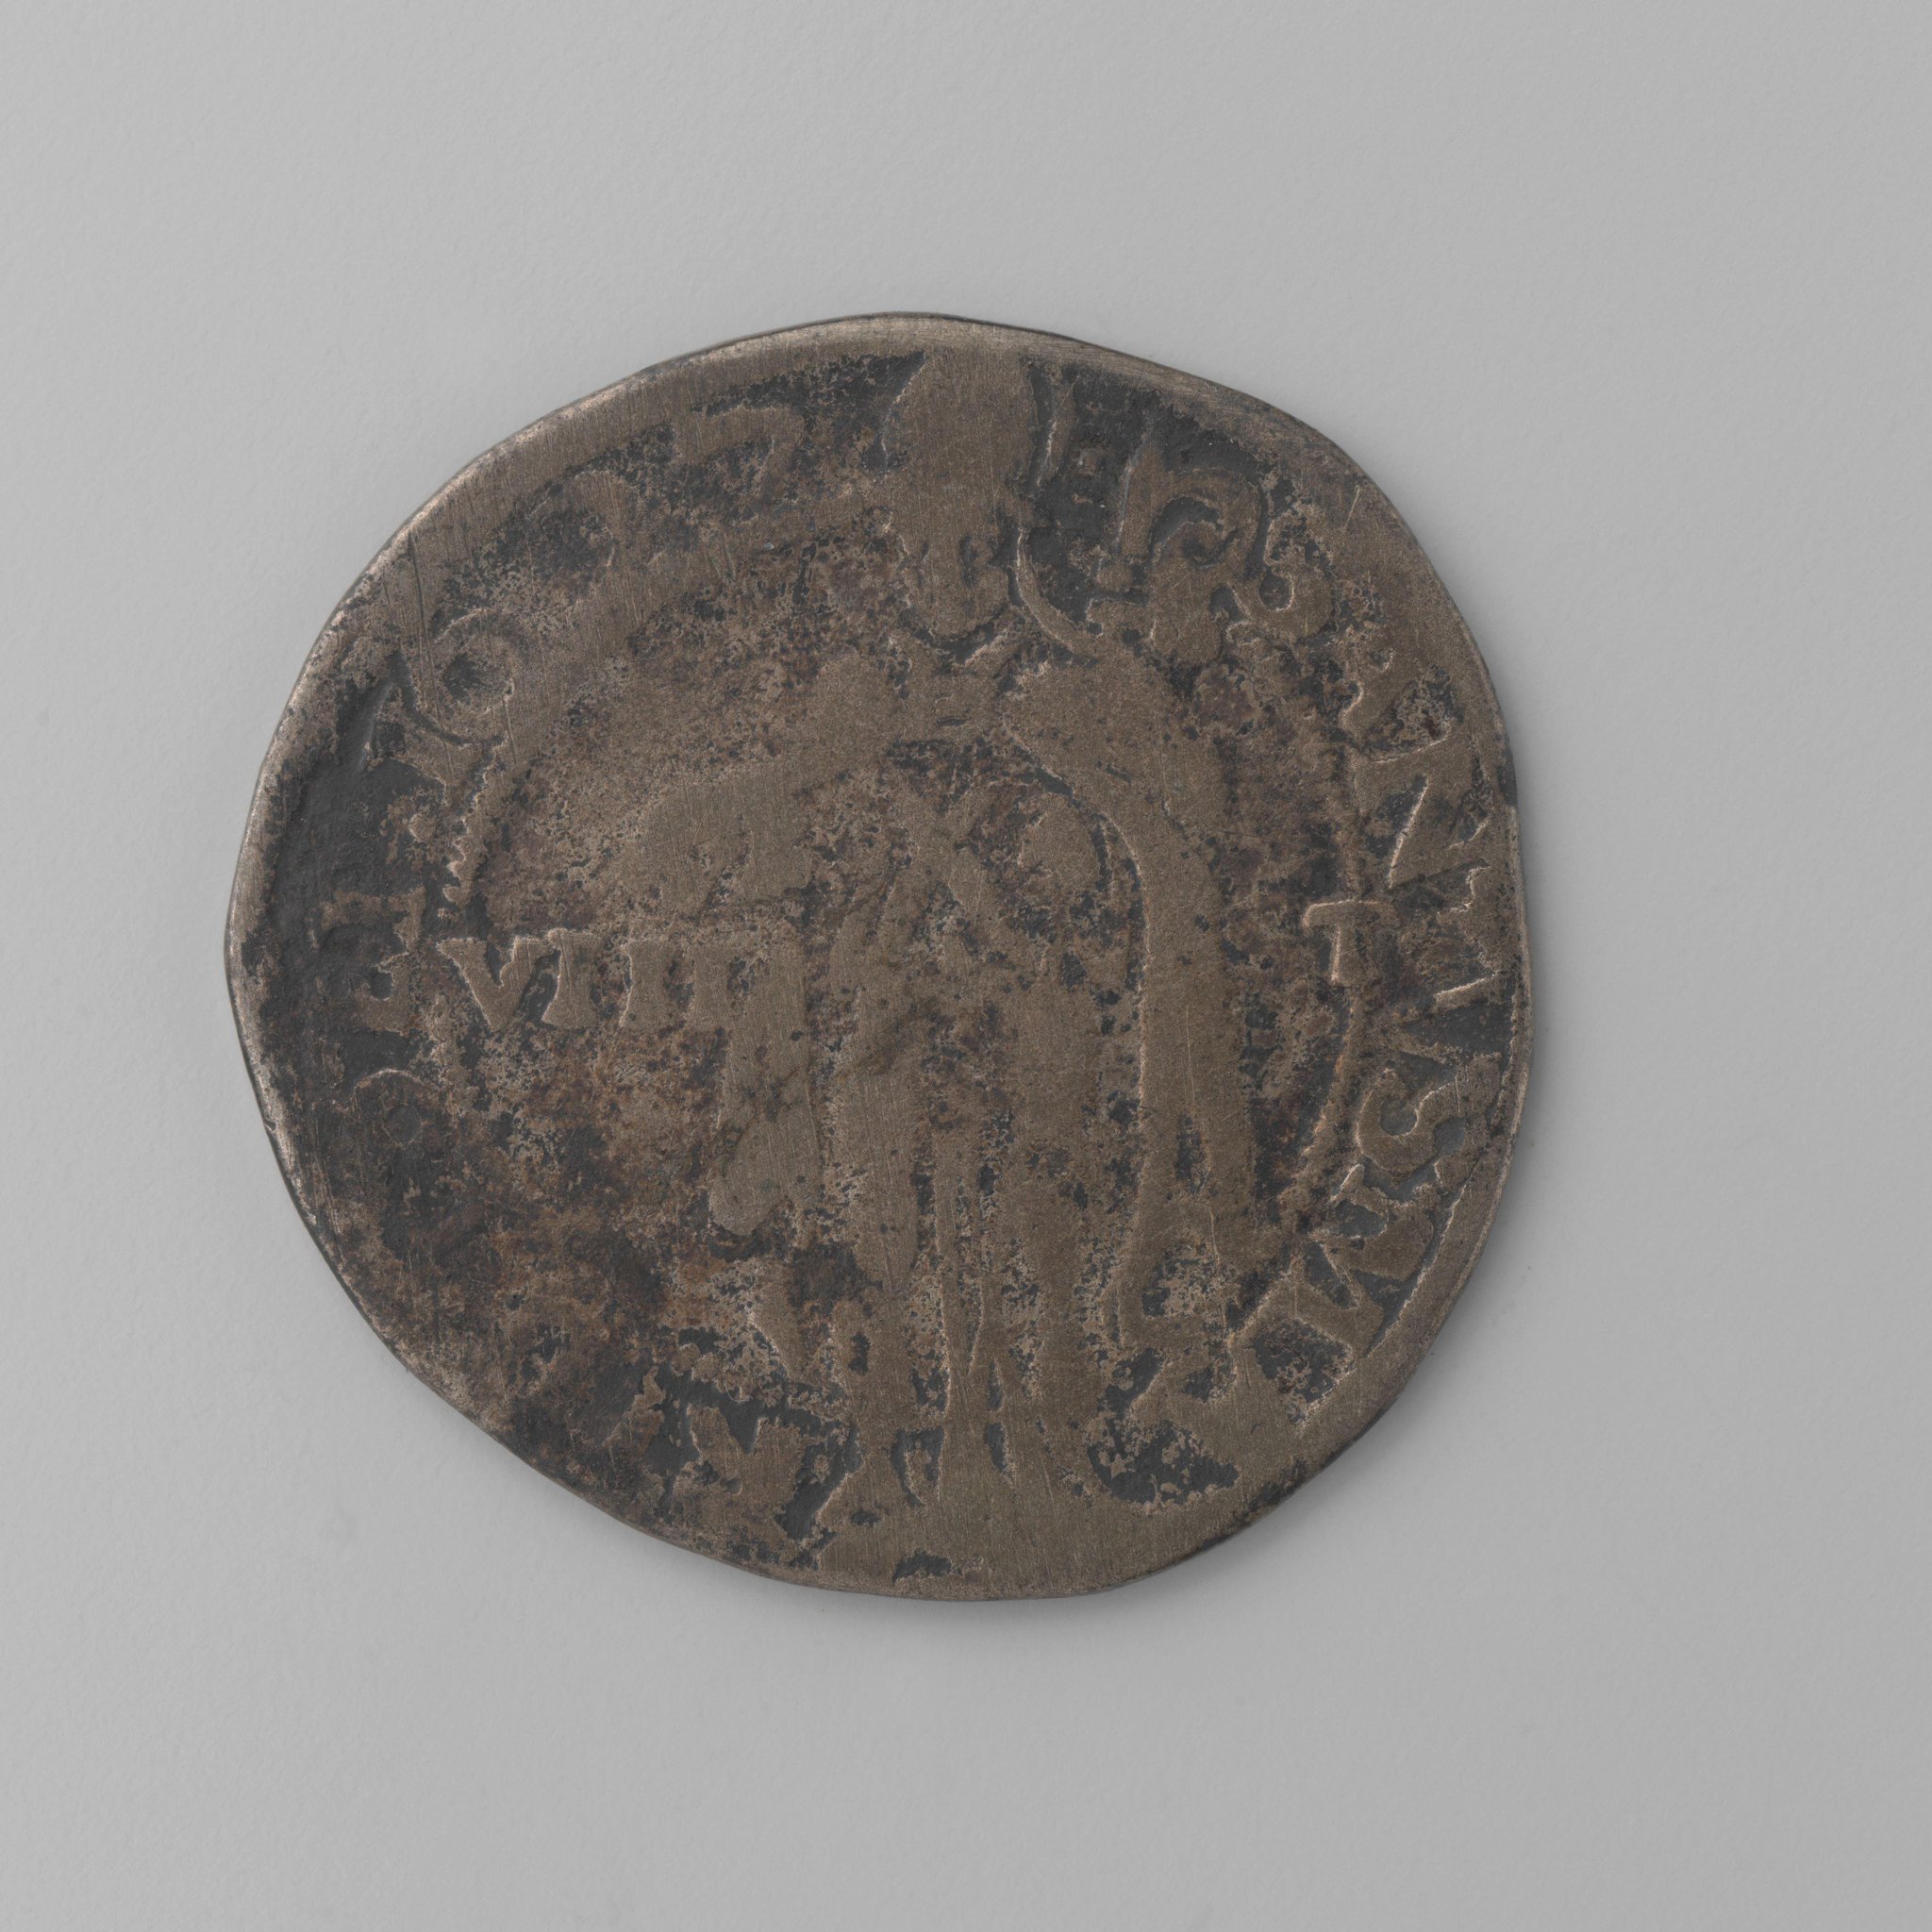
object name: coin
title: Groningen, langrok of 8 stuiver, 1627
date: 1627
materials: silver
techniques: striking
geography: groningen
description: Zilveren munt. Voorzijde: tussen waarde-aanduiding VIII ST staande heilige Martinus met staf in lang gewaad. Jaartal in omschrift. Keerzijde: dubbelkoppige adelaar, waarop wapenschild.